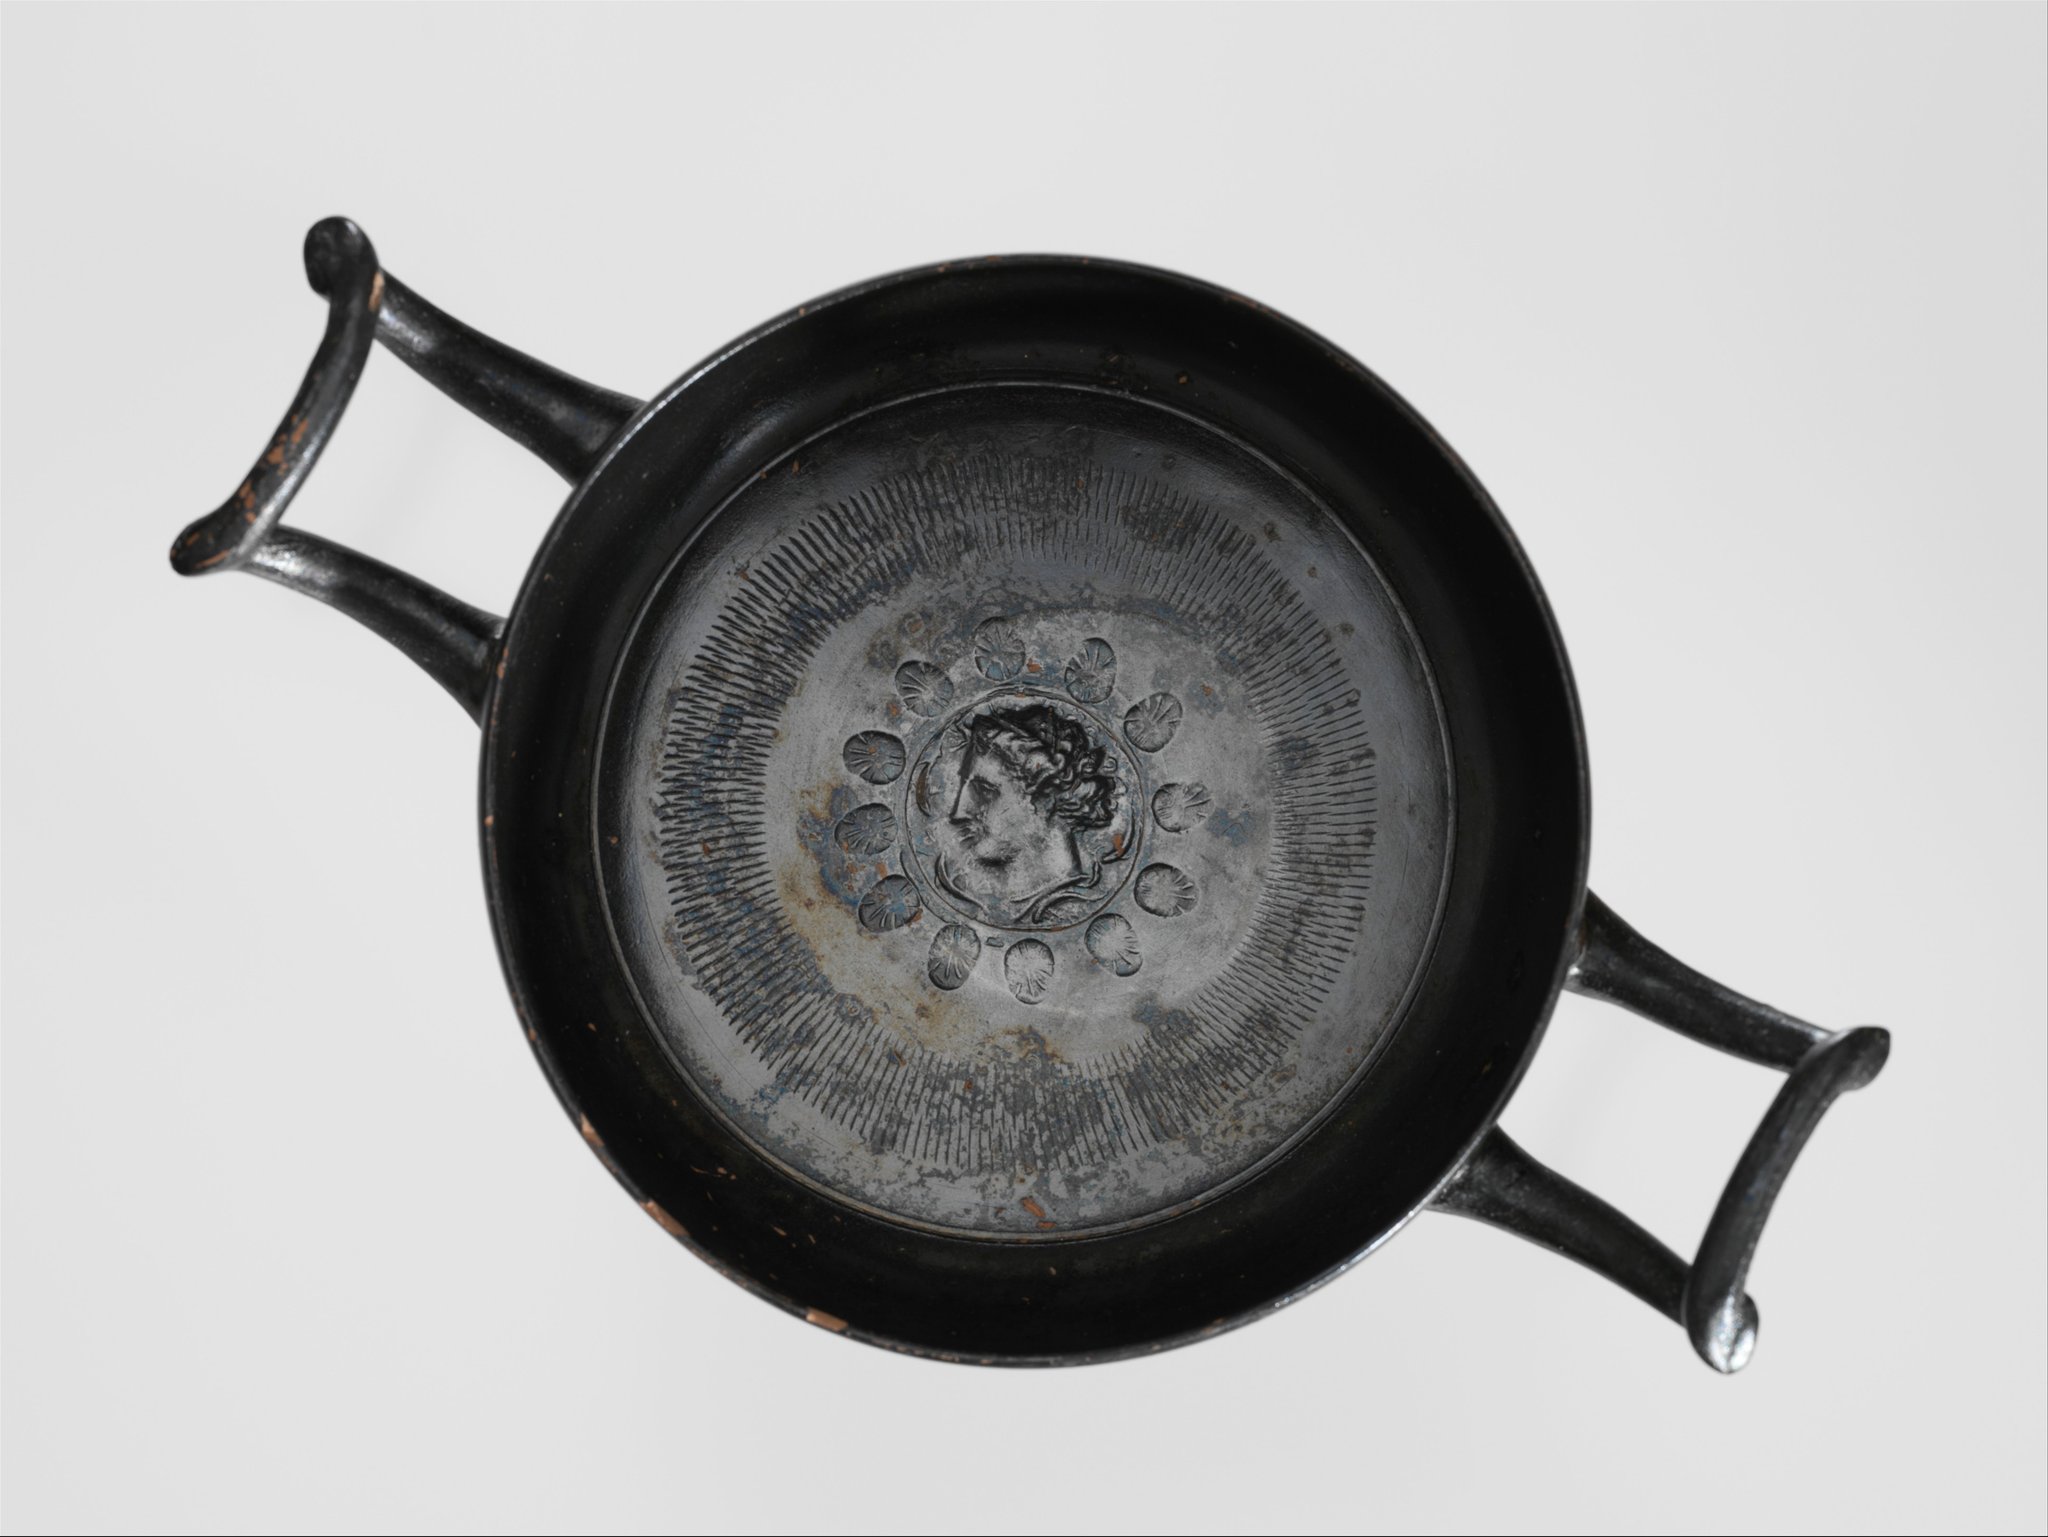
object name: kylix, stemless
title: Terracotta stemless kylix (drinking cup)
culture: greek, calenian or campanian or south italian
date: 334-201 BCE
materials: terracotta